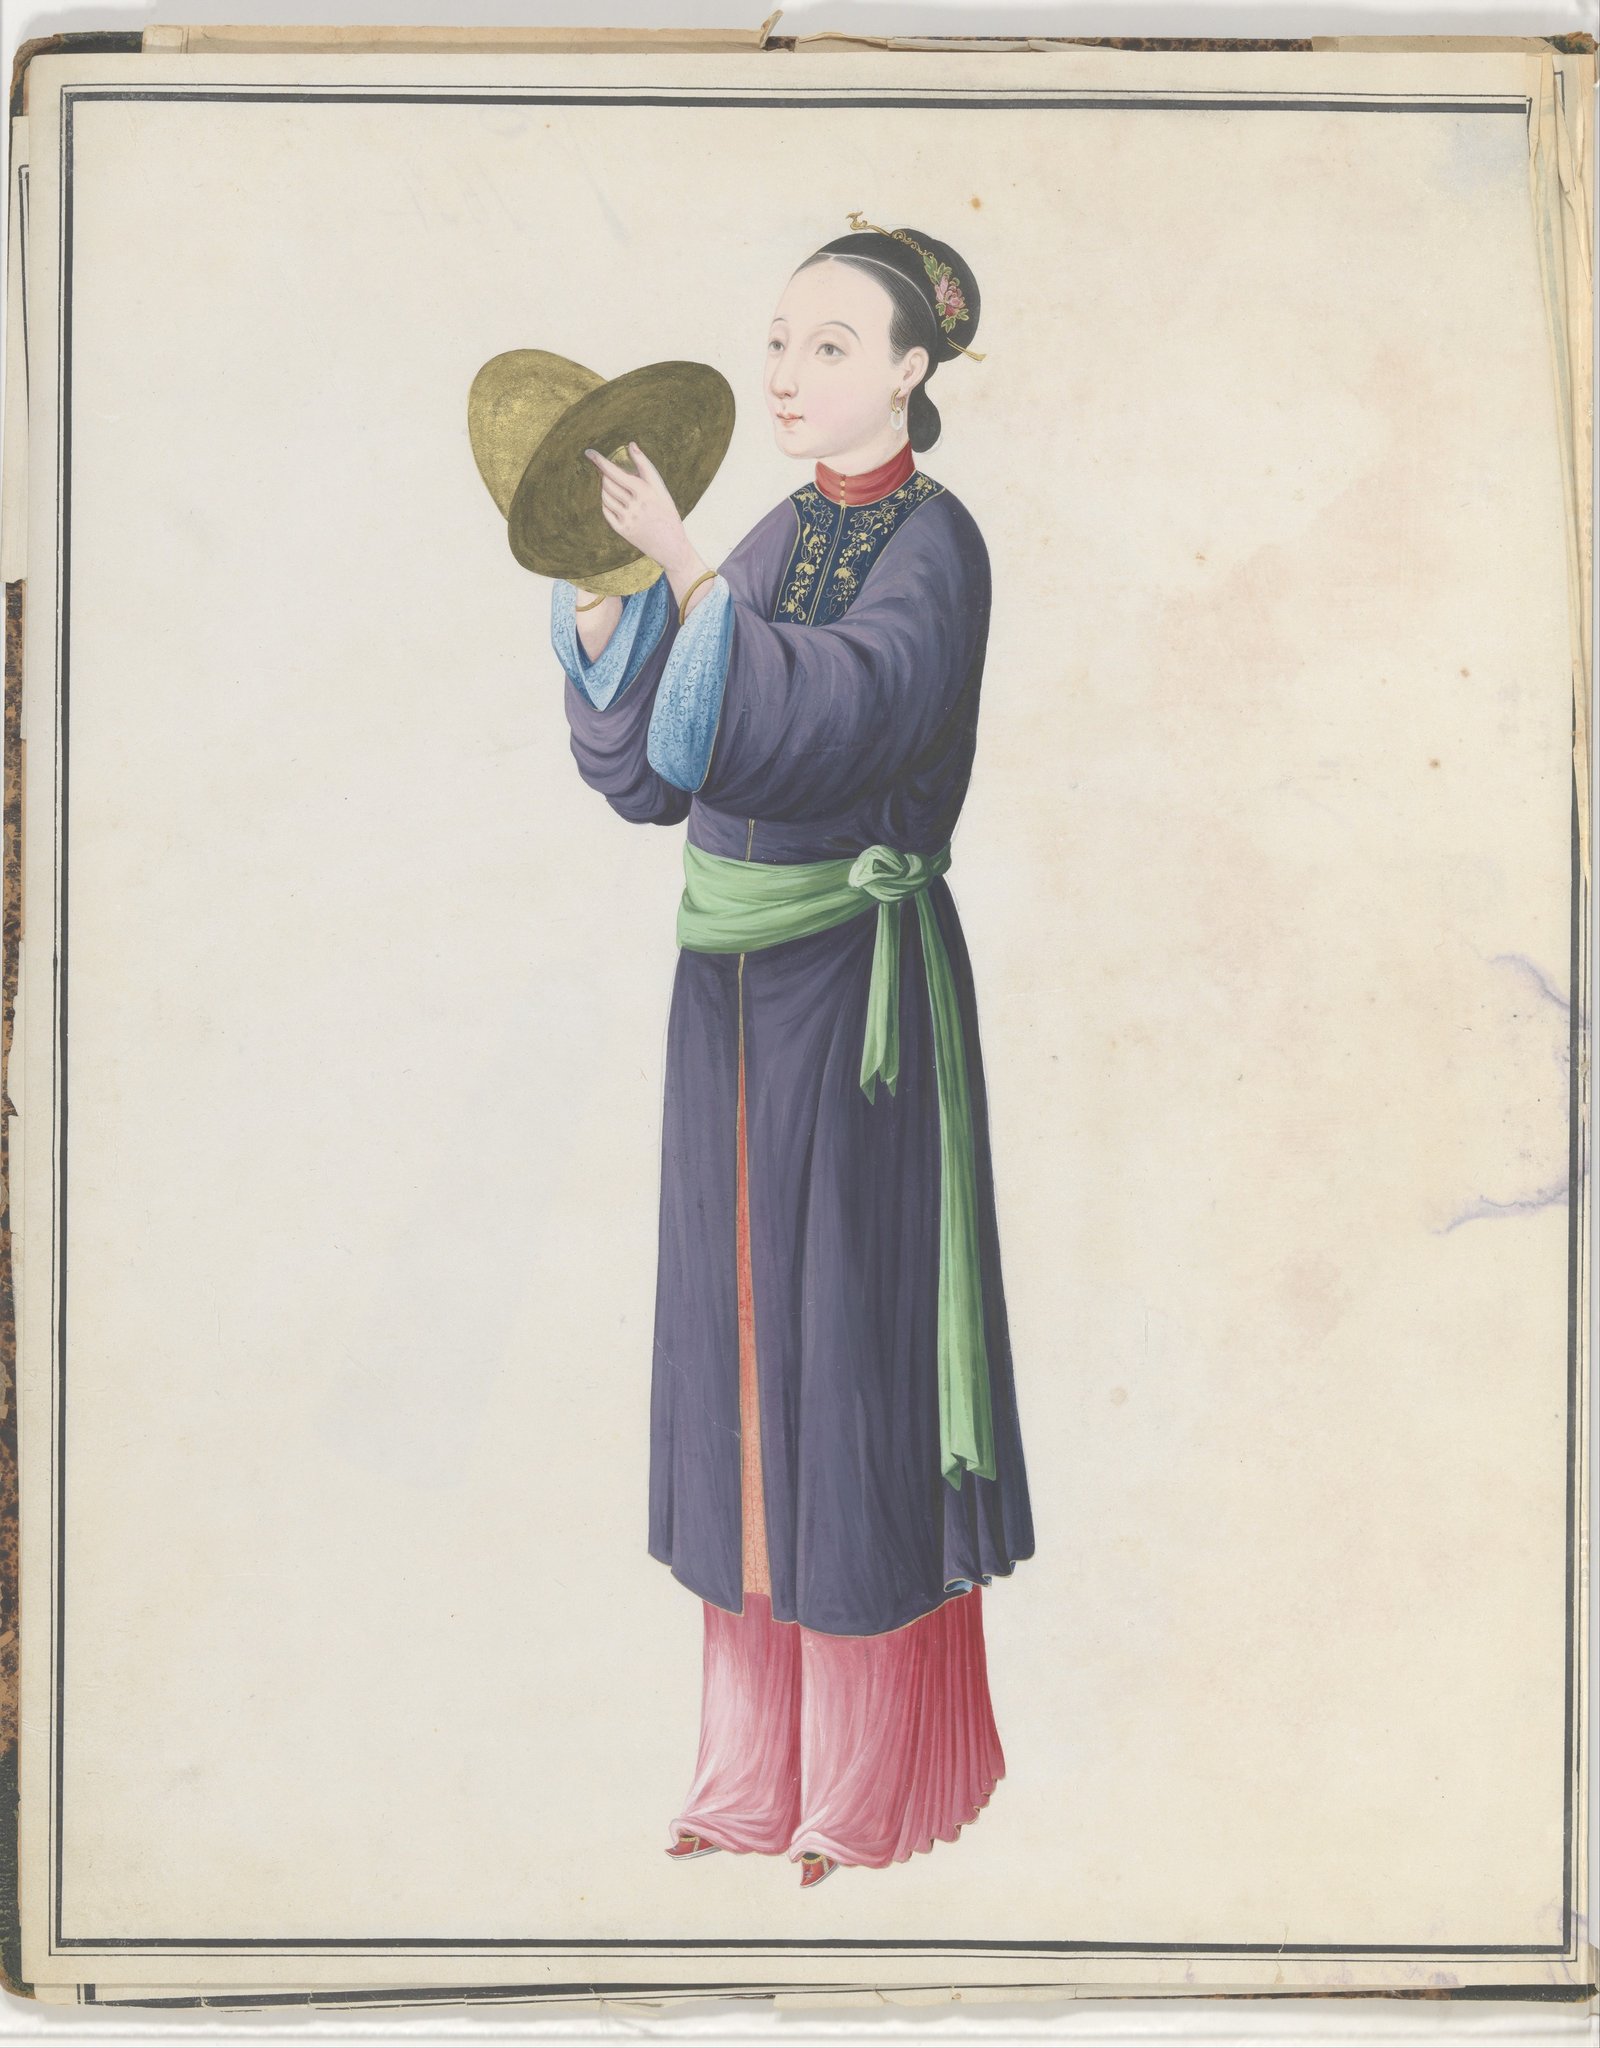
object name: watercolor of musician playing bo tongbo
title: Watercolor of musician playing bo (tongbo)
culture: chinese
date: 1767-1800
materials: paper, watercolor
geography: china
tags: musical instruments,women,musicians